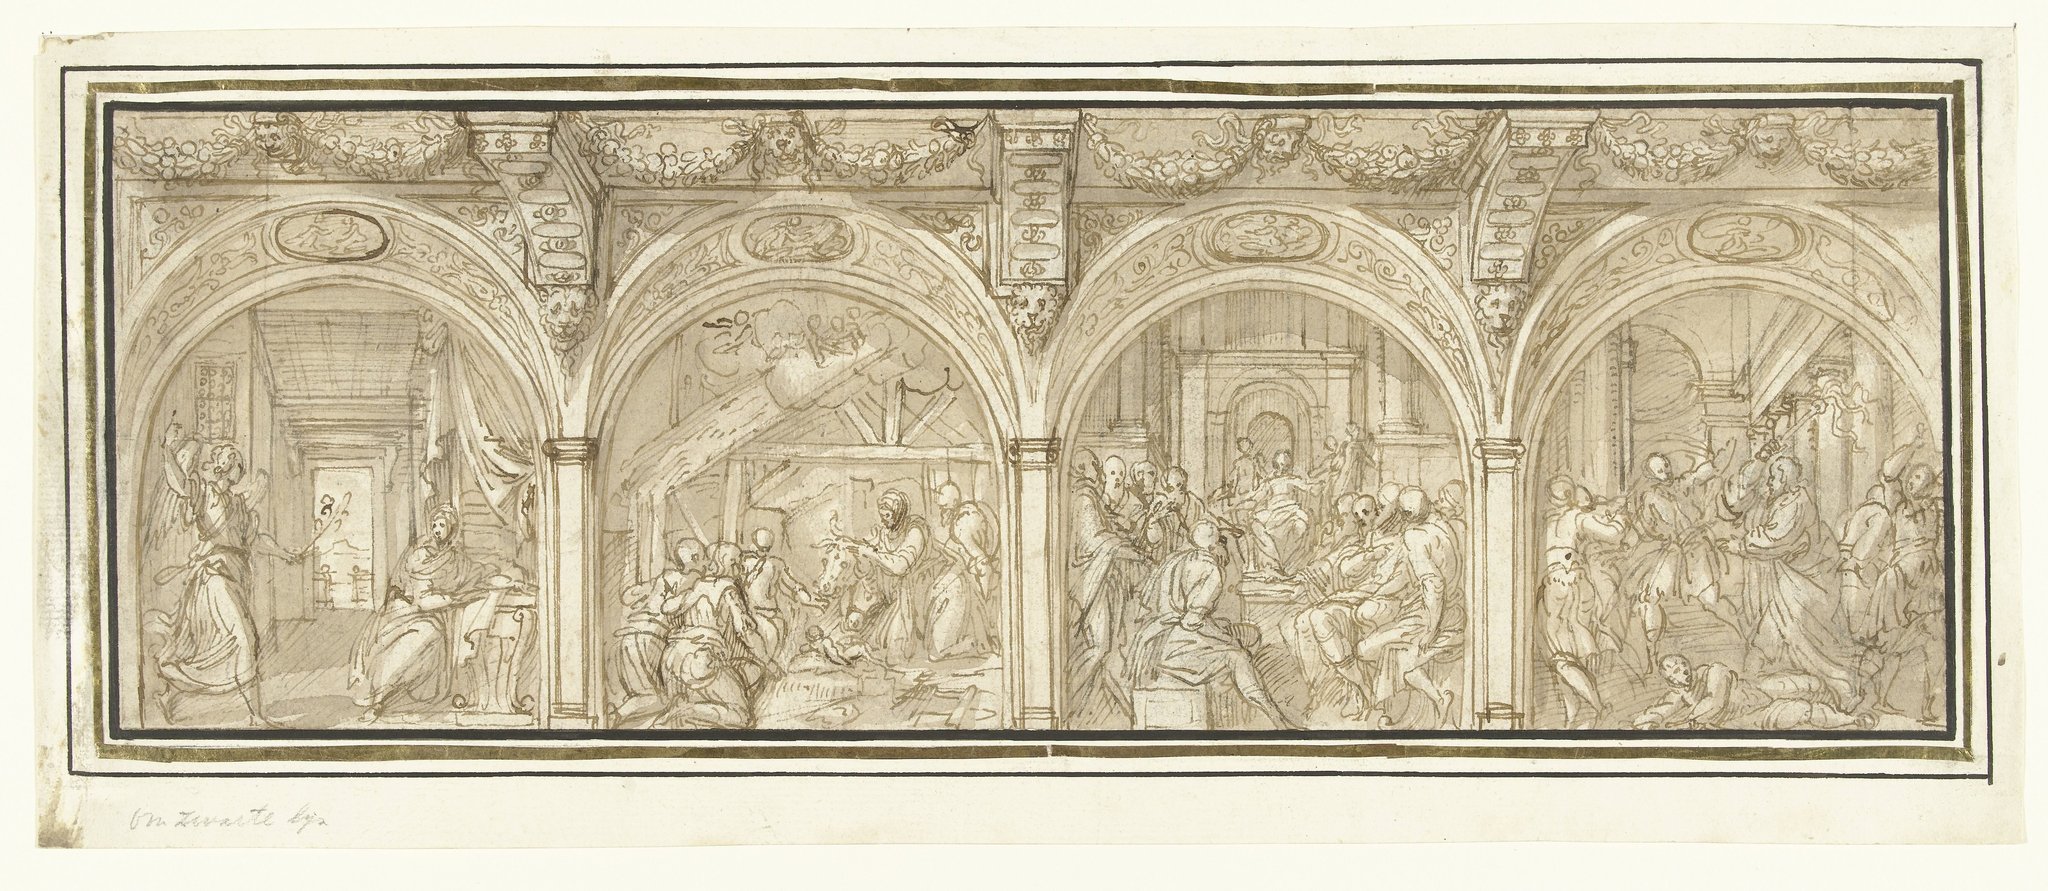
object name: design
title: Ontwerp voor een muurdecoratie met vier voorstellingen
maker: lattanzio gambara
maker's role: draughtsman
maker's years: 1530-1574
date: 1540-1573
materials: chalk, ink, paper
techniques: brush, pen